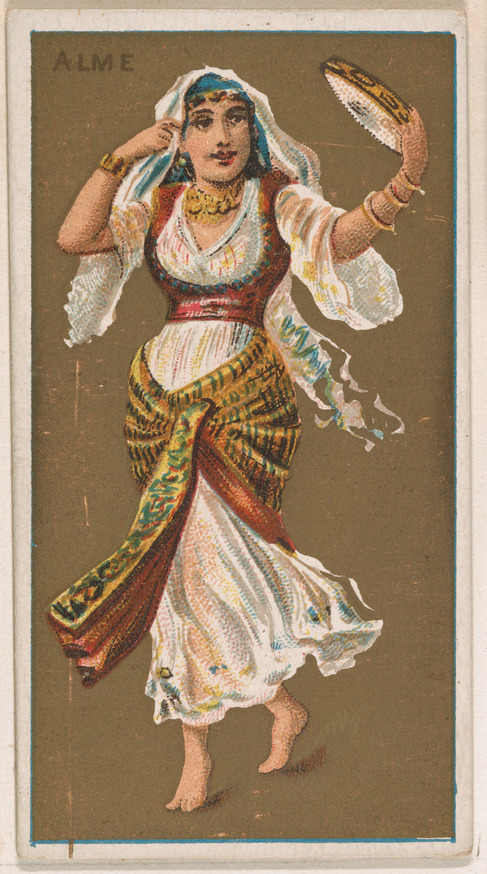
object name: print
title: Alme, from National Dances (N225, Type 1) issued by Kinney Bros.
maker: kinney brothers tobacco company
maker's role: publisher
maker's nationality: american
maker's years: 1869-2011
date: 1889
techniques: color lithograph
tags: women,dancers